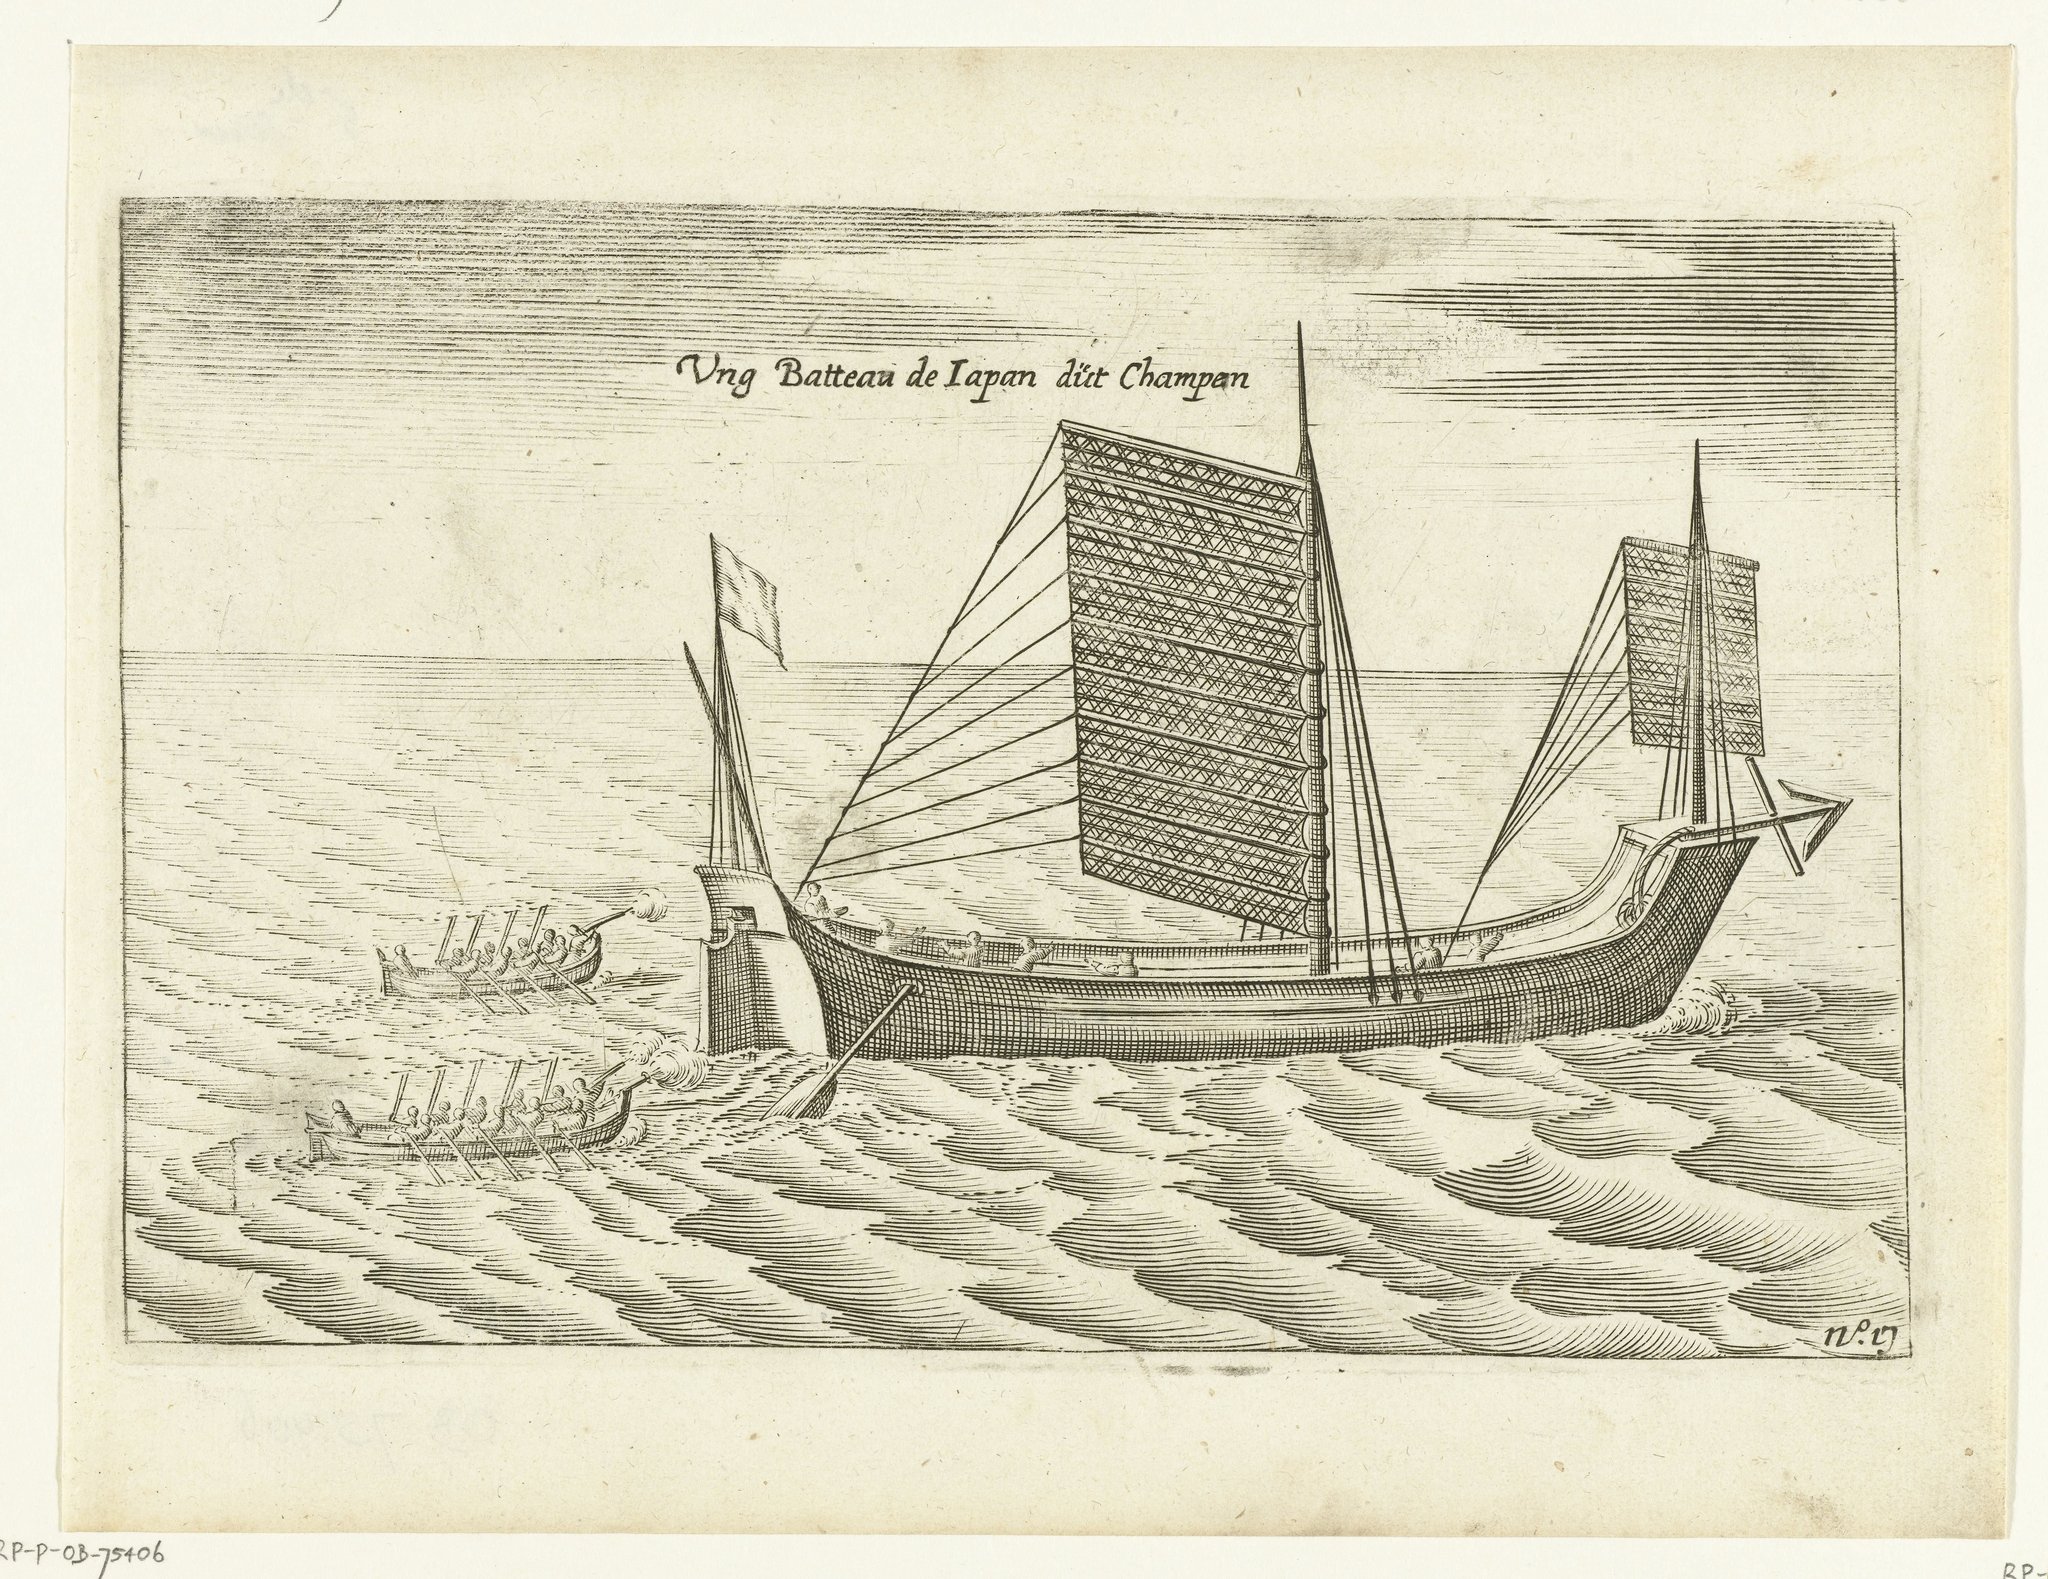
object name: print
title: Een Japans vaartuig, 1600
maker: Anonymous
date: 1601-1602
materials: paper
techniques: engraving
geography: northern netherlands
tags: utrecht, ships (in general) (+ propulsion of vehicle, ship, etc. by wind), landscapes in tropical and sub-tropical regions, exploration, expedition, voyage of discovery, japan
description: Gebruikt als illustratie eerst in: O. van Noort, Beschryvinghe vande voyagie om den geheelen werelt cloot, ghedaen door Olivier van Noort van Utrecht. ... door de Strate Magellanes, ... langs de custen van Cica, Chili ende Peru, om den gantschen aerden cloot, ende door de Molucques wederom thuys te comen. : Te zeyl gegaen van Rotterdam ... 1598. Ende ... weder ghekeert ... 1601. Daer in dat vertelt wort zyne wonderlijcke avontueren, Jan van Waesberge (II) te Rotterdam en Cornelis Claes te Amsterdam 1602. Later gebruikt in: Oost-Indische ende West-Indische voyagien, Michiel Colijn, Amsterdam 1619 en in deze staat eerst gebruikt in: Beschrijvinge van de Schipvaerd by de Hollanders ghedaen onder 't beleydt ende Generaelschap van Olivier van Noort, door de Straet of Engte van Magallanes, ende voorts de gantsche kloot des Aertbodems om. Opgenomen in: I. Commelin, Begin ende voortgangh, van de Vereenighde Nederlantsche Geoctroyeerde Oost-Indische Compagnie, J. Janssonius, Amsterdam 1646. Genummerd: 17.